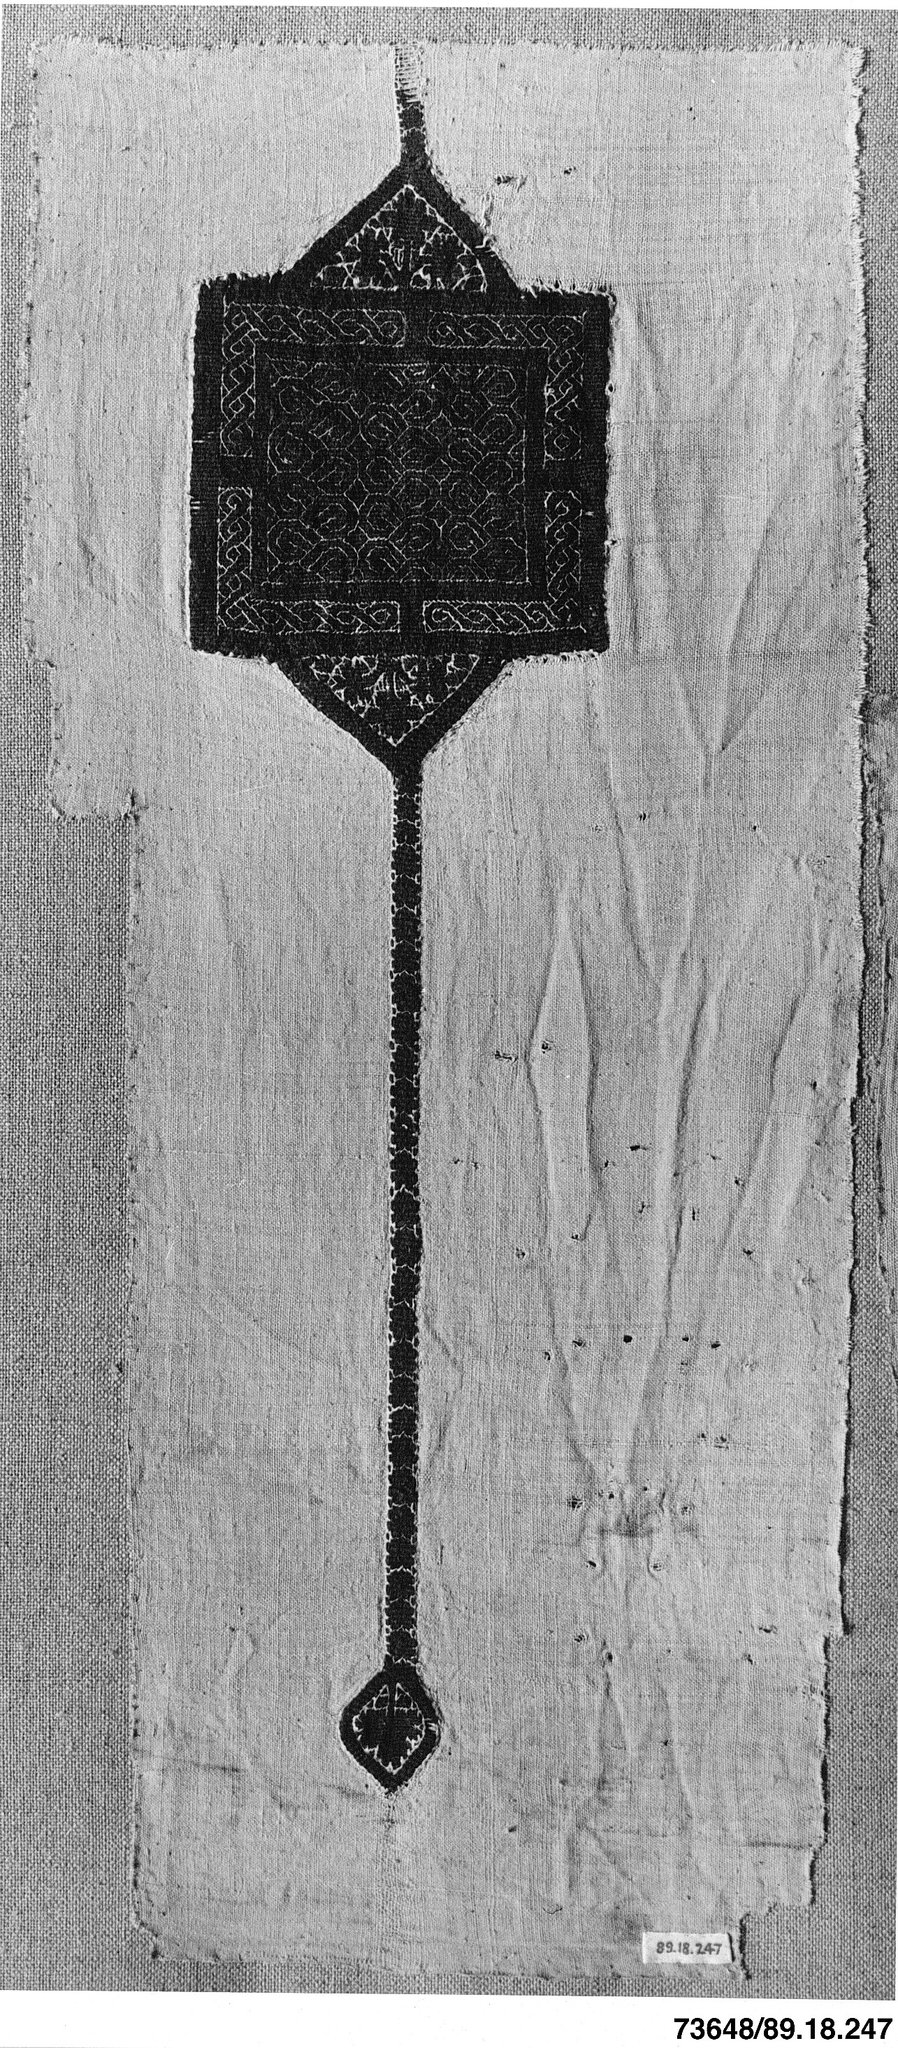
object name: textile fragment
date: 201-400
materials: linen, wool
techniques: weave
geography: egypt